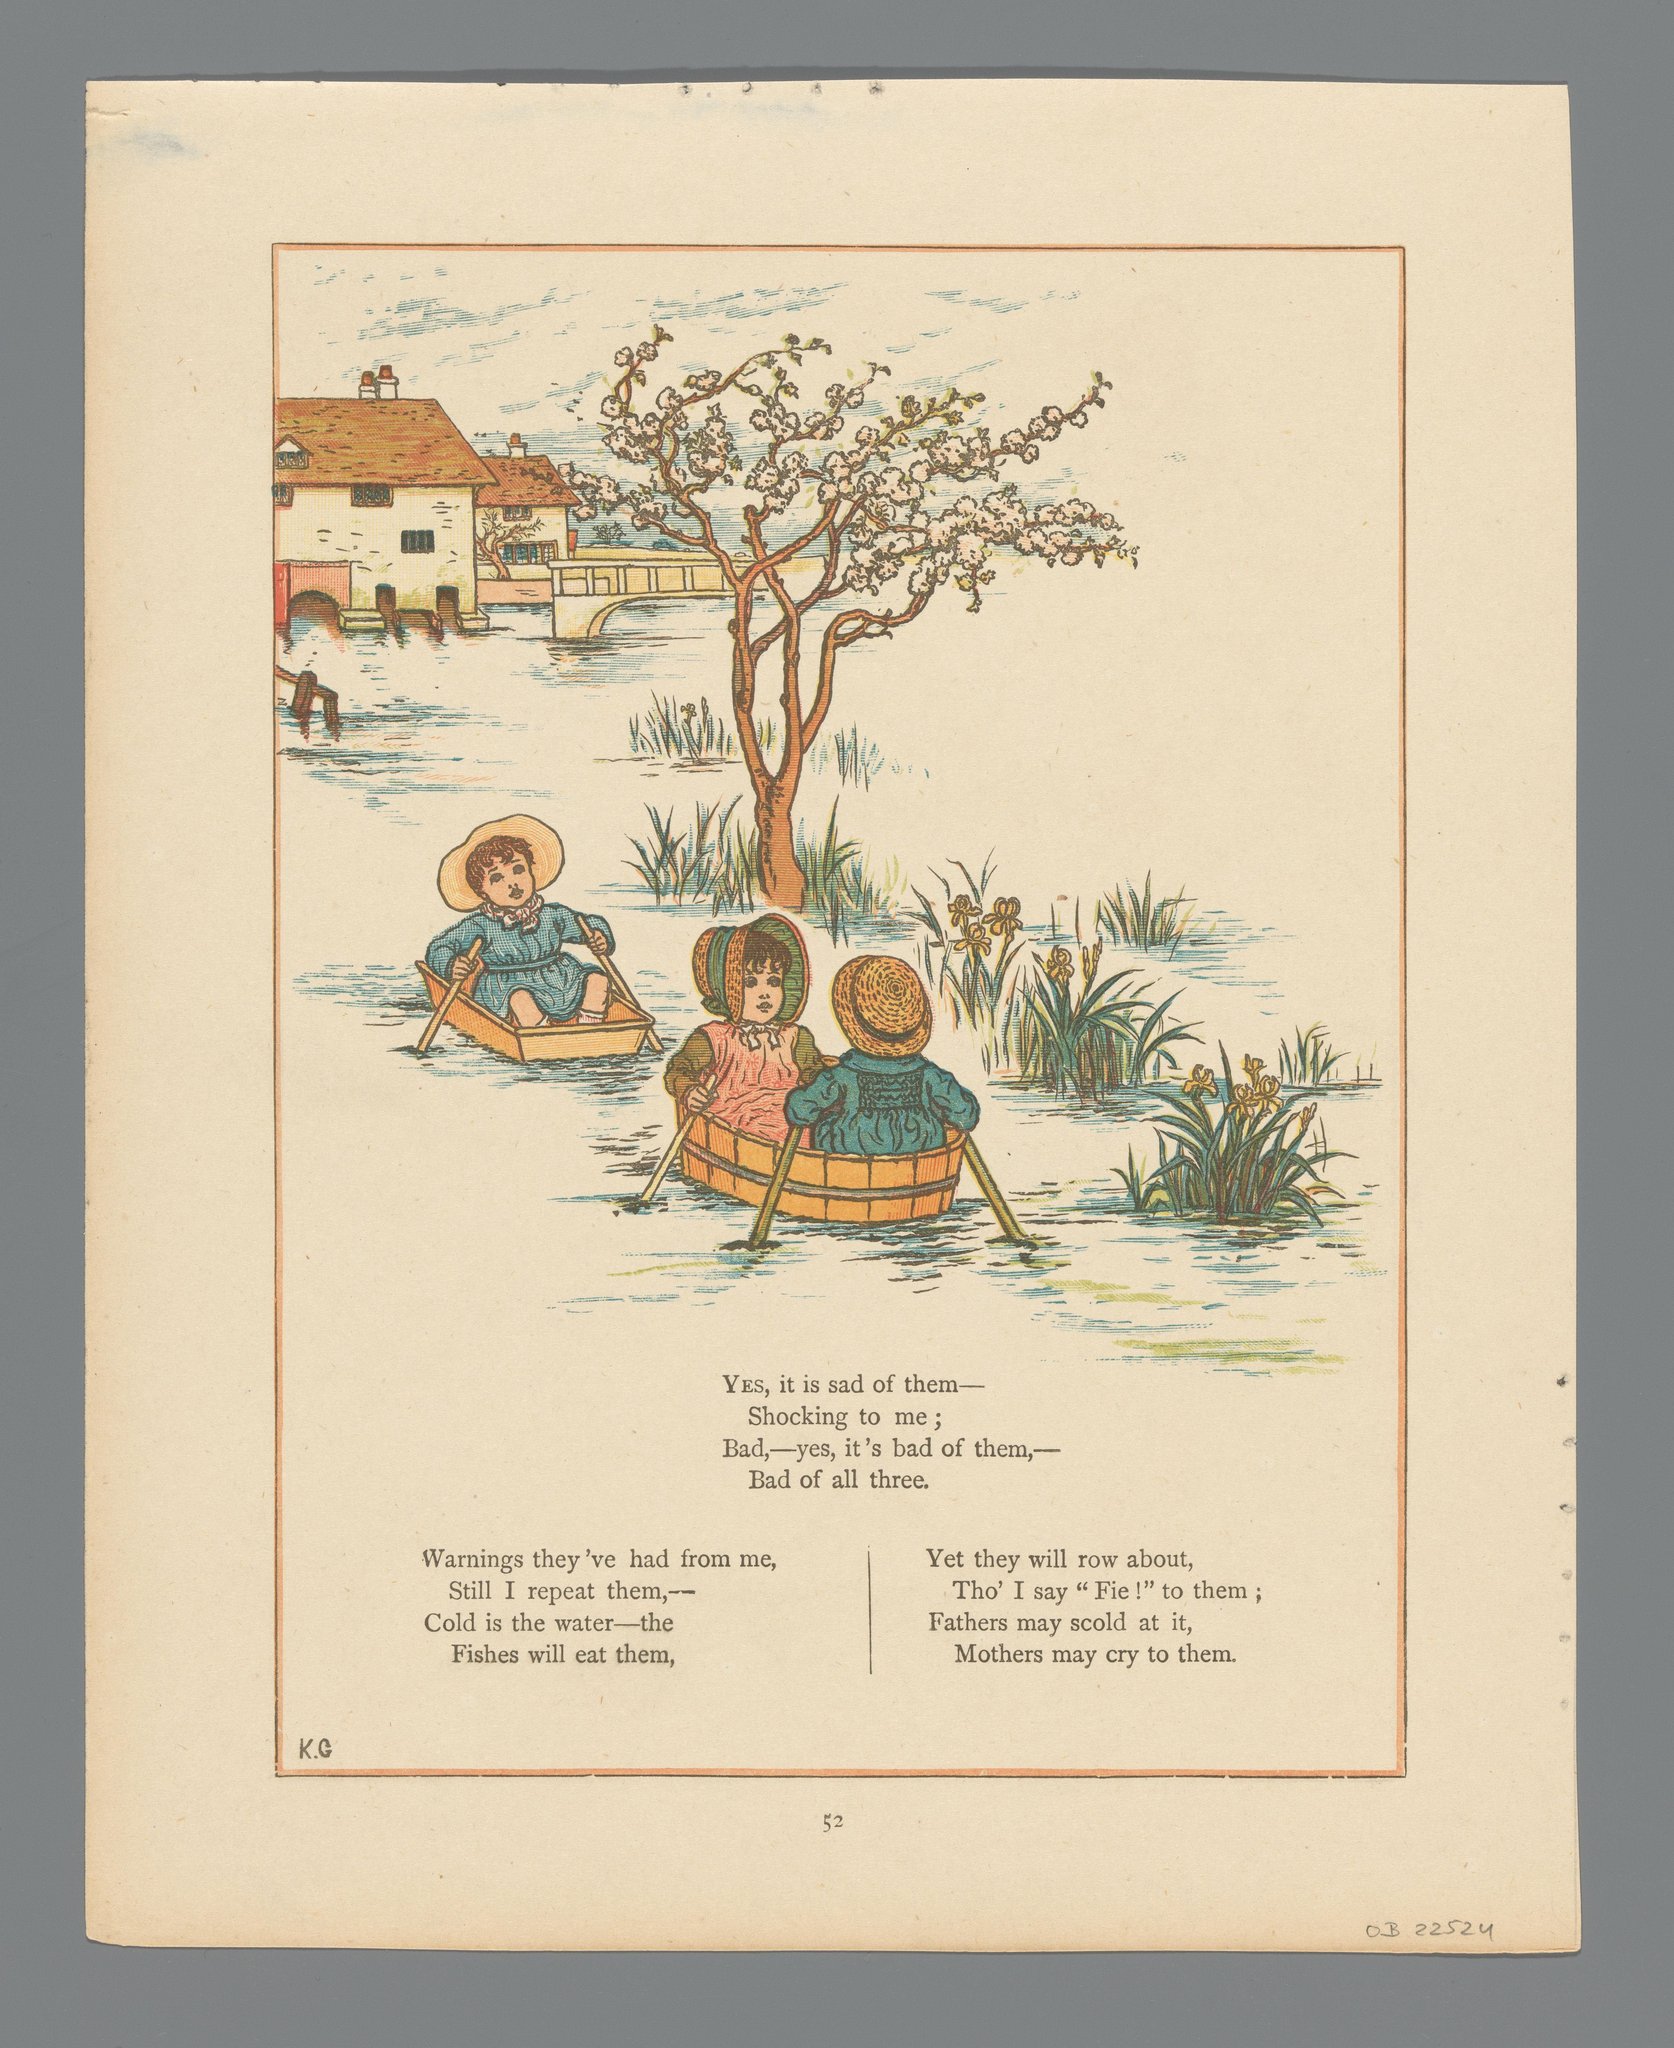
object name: book illustration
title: Drie kinderen roeiend in een ton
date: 1878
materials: paper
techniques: wood engraving, letterpress printing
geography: london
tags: rowing-boat, canoe, etc., child (+ three persons)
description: Prent uit: Greenaway, Kate. Under the window, pictures & rhymes for children. Londen: George Routledge & Sons, 1878, p. 52.